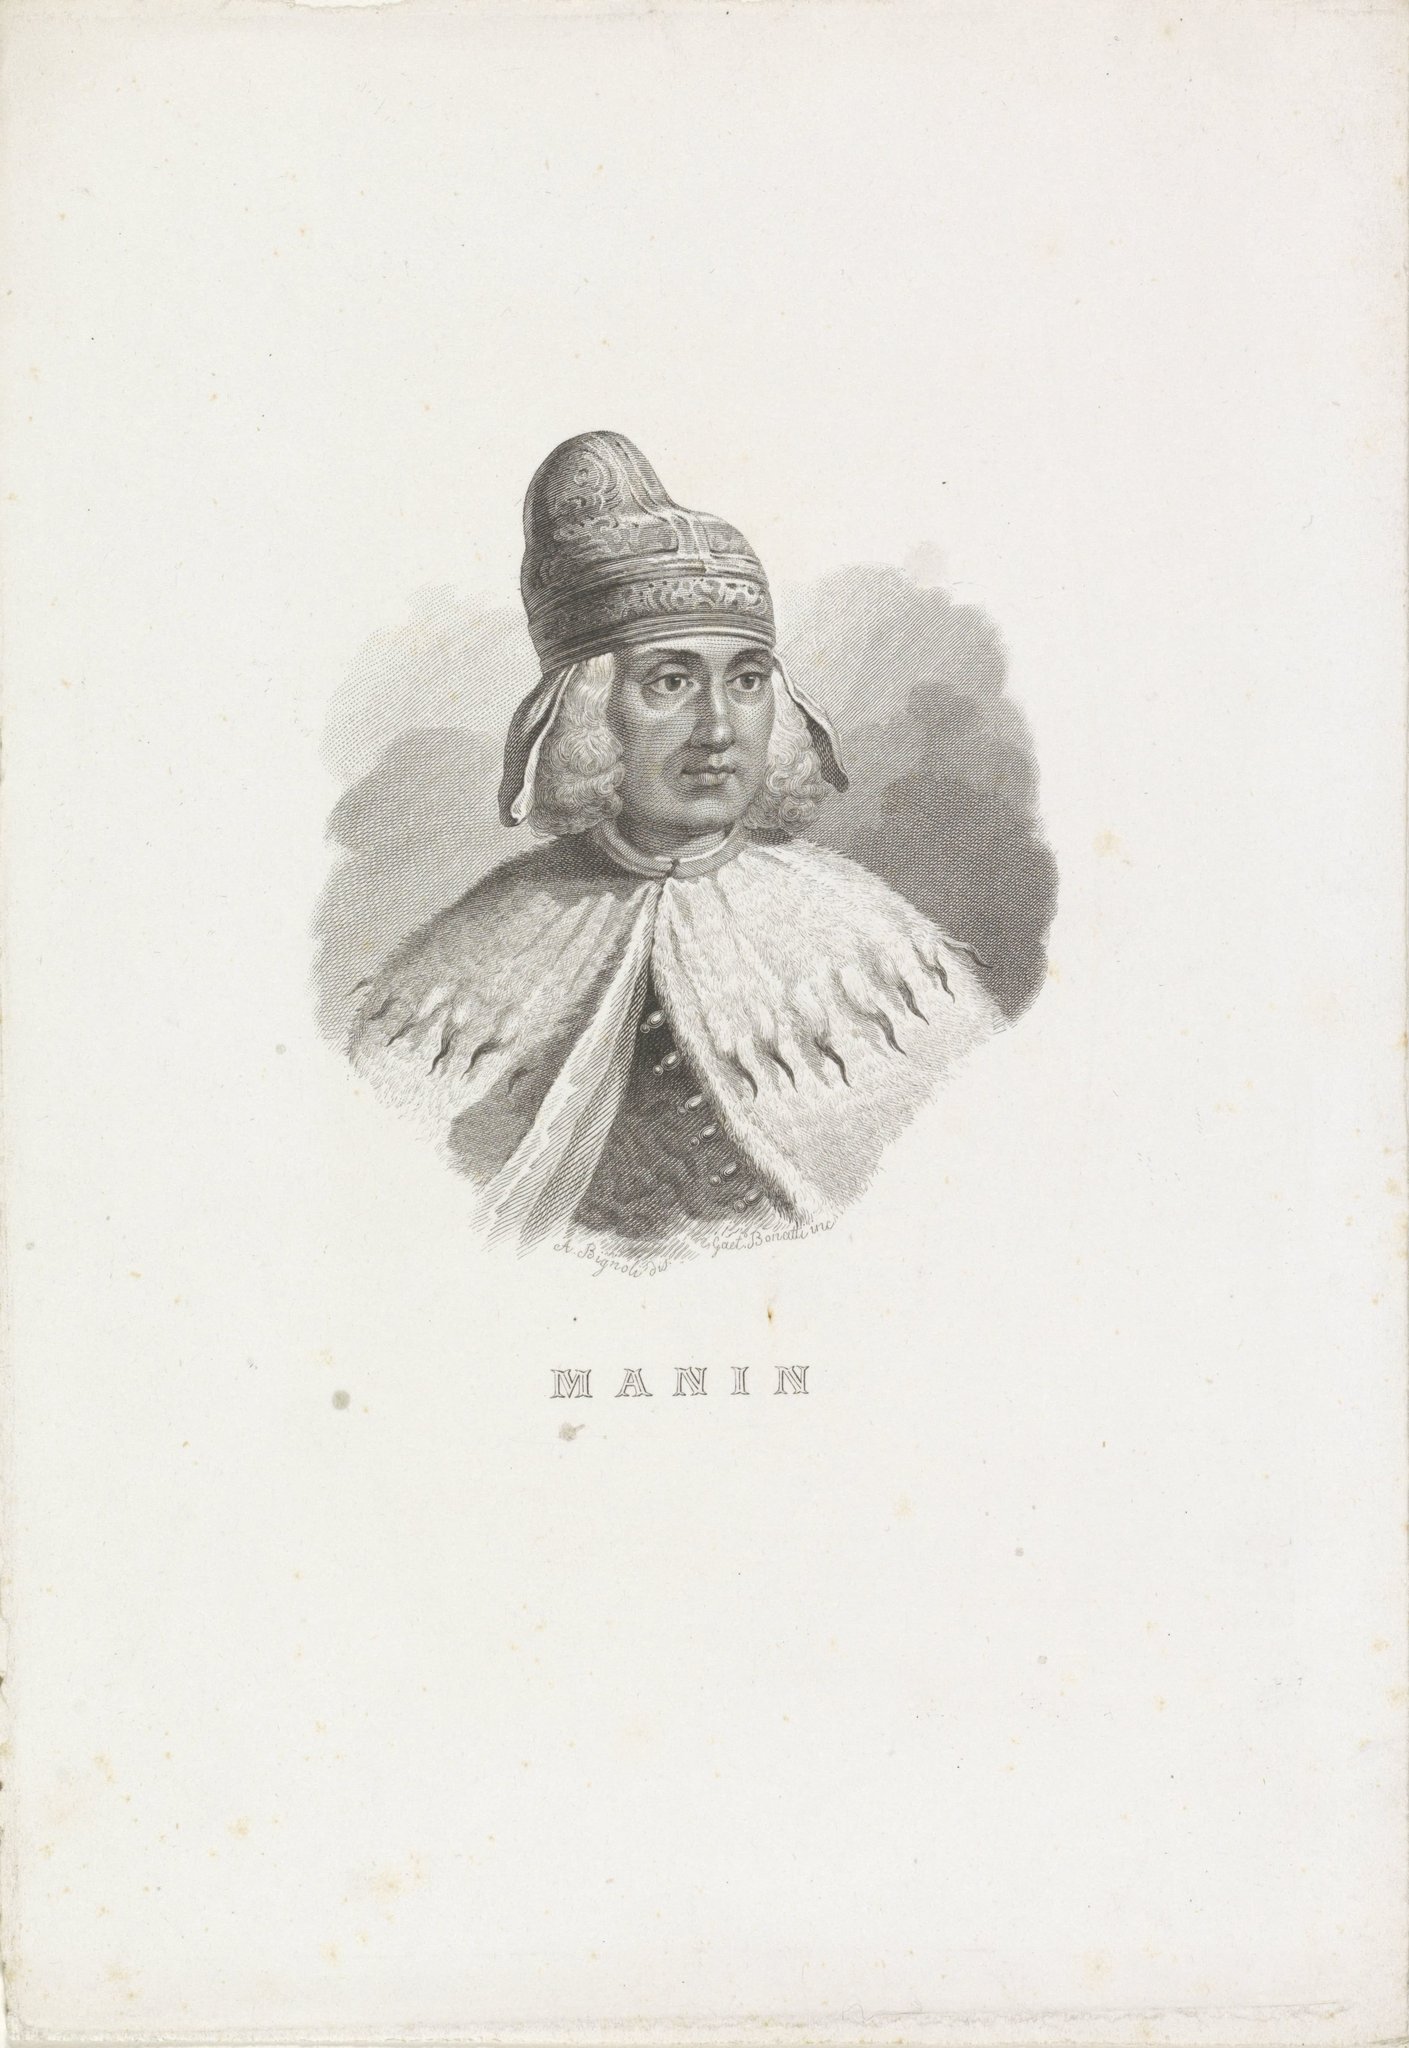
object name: print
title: Portret van Doge Ludovico Manin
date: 1845-1855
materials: paper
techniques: engraving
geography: italy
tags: historical persons, other sovereign: doge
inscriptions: collector's mark: Lugt 2228